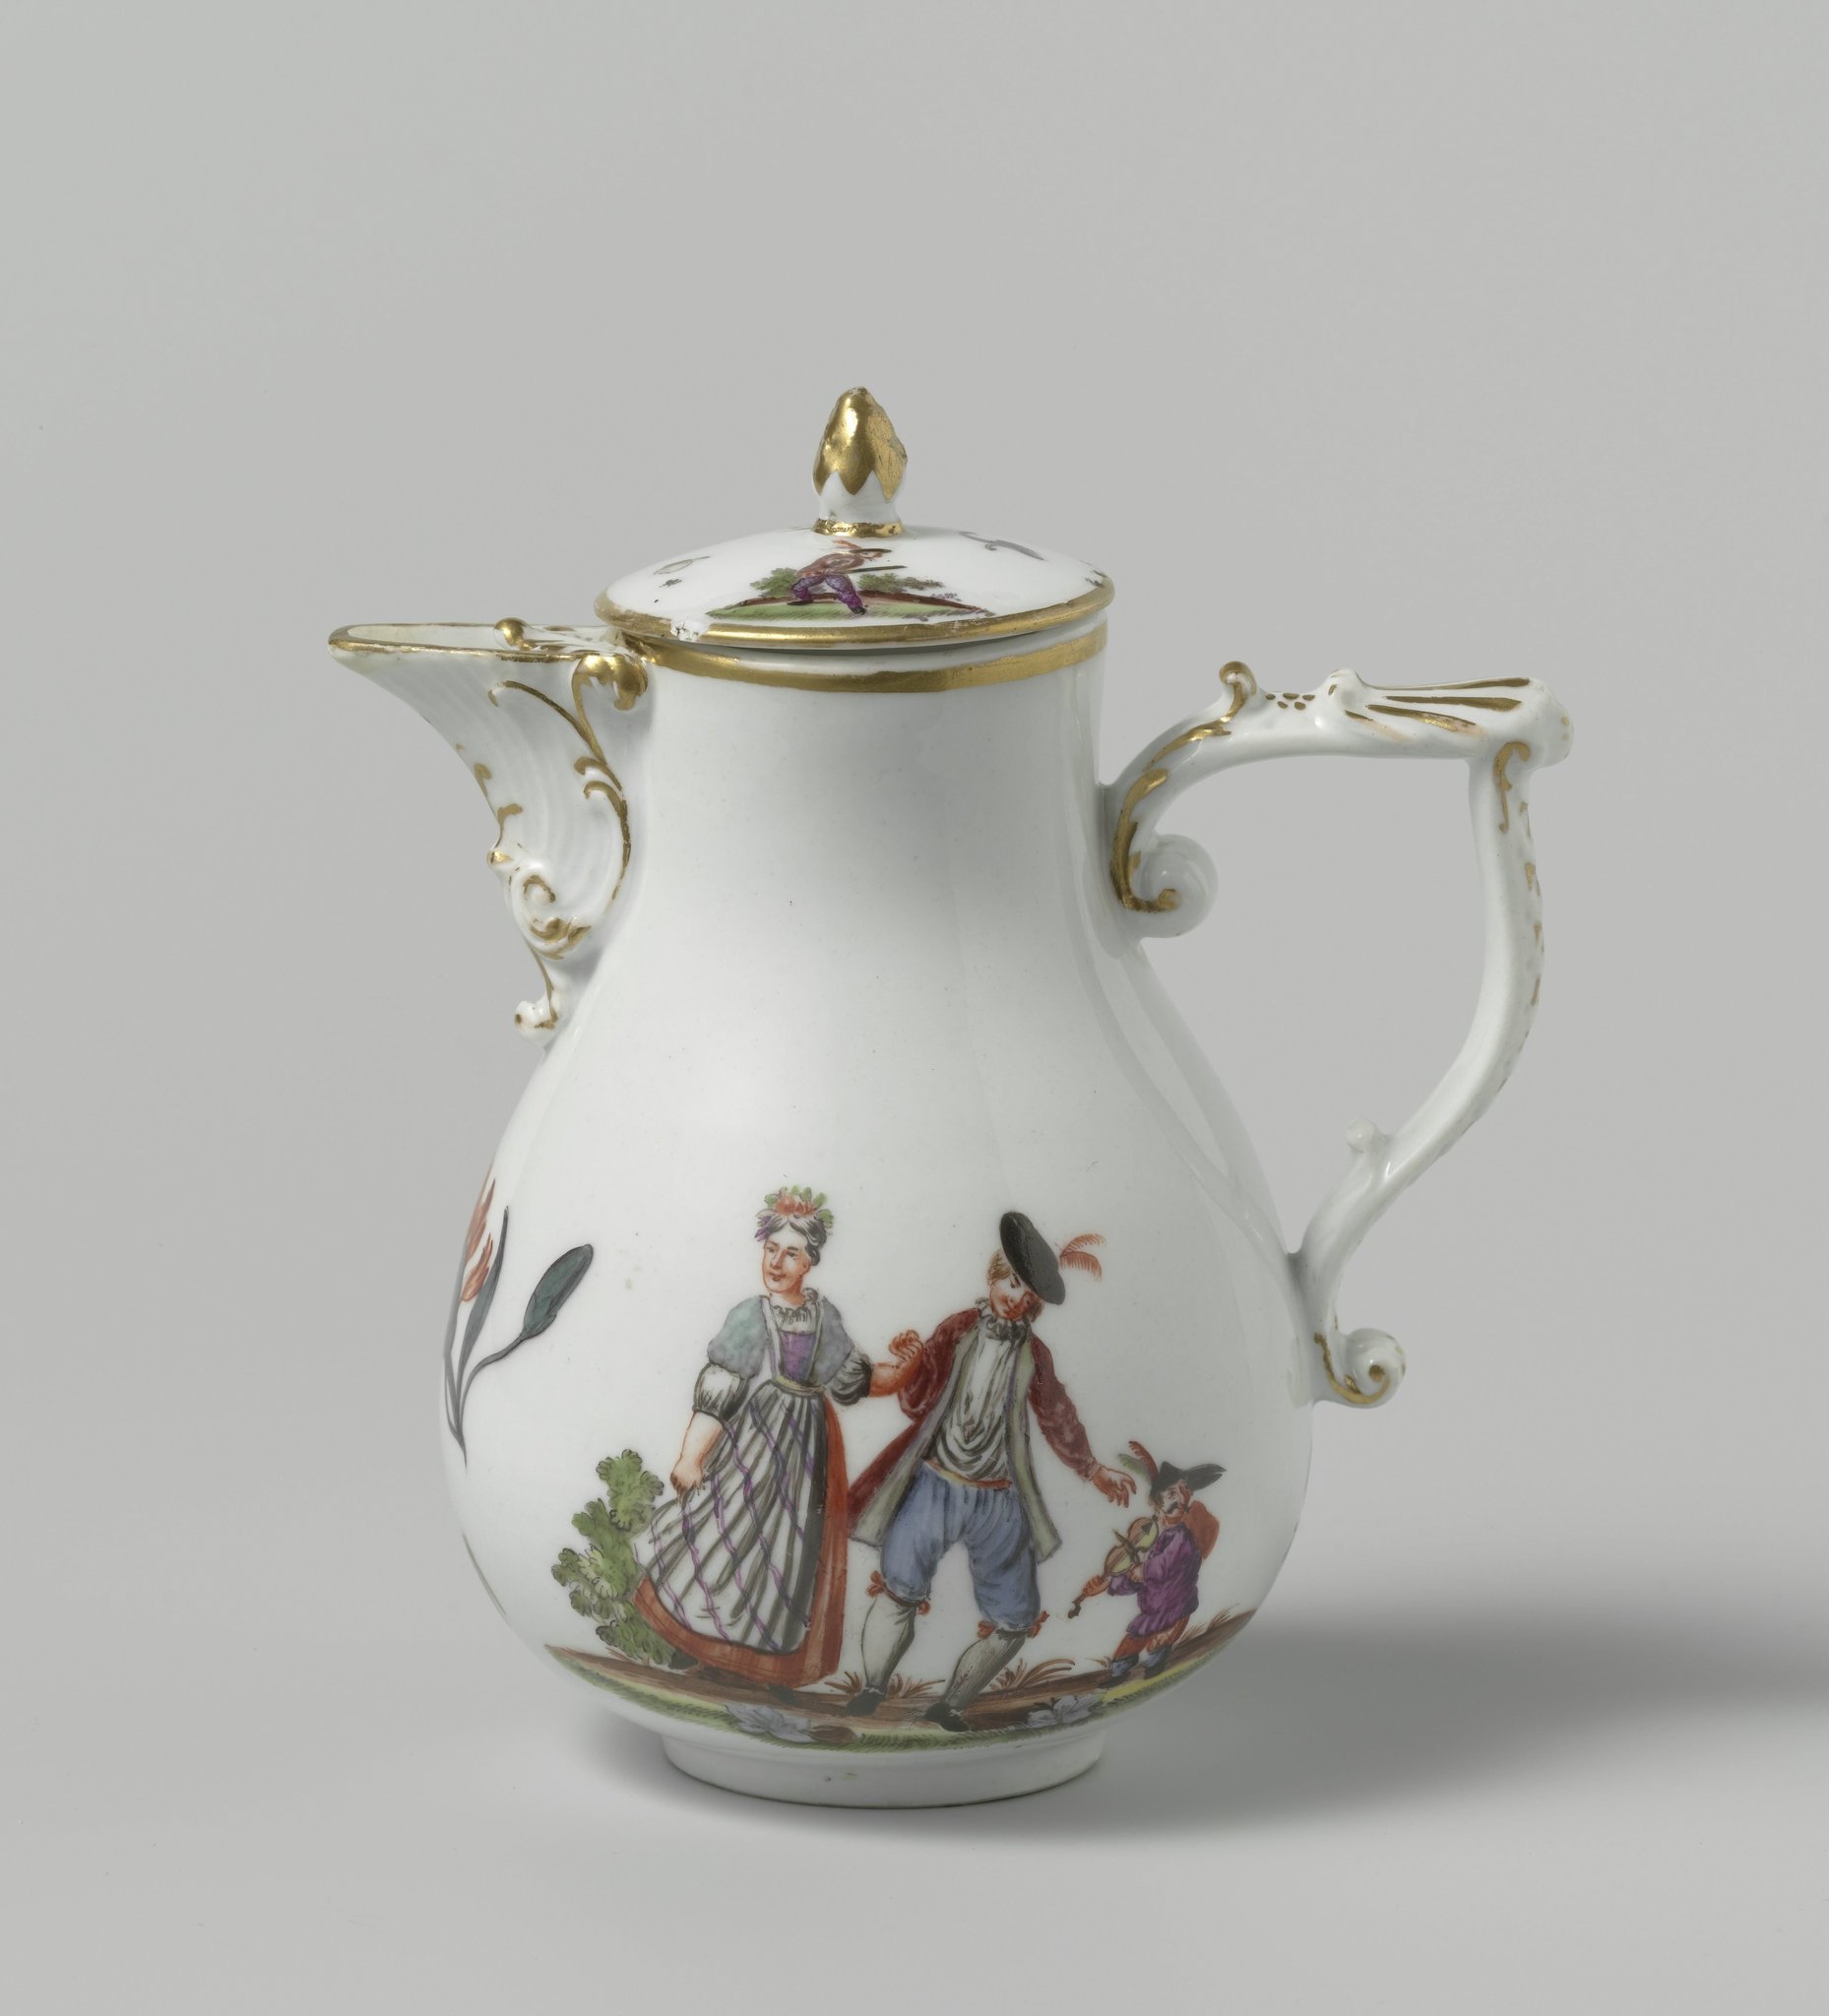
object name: milk jug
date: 1740-1745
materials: porcelain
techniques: painted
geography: meissen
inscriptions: factory mark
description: Meissener Porzellan Manufaktur Meissen, c. 1740–1745 hard-paste porcelain